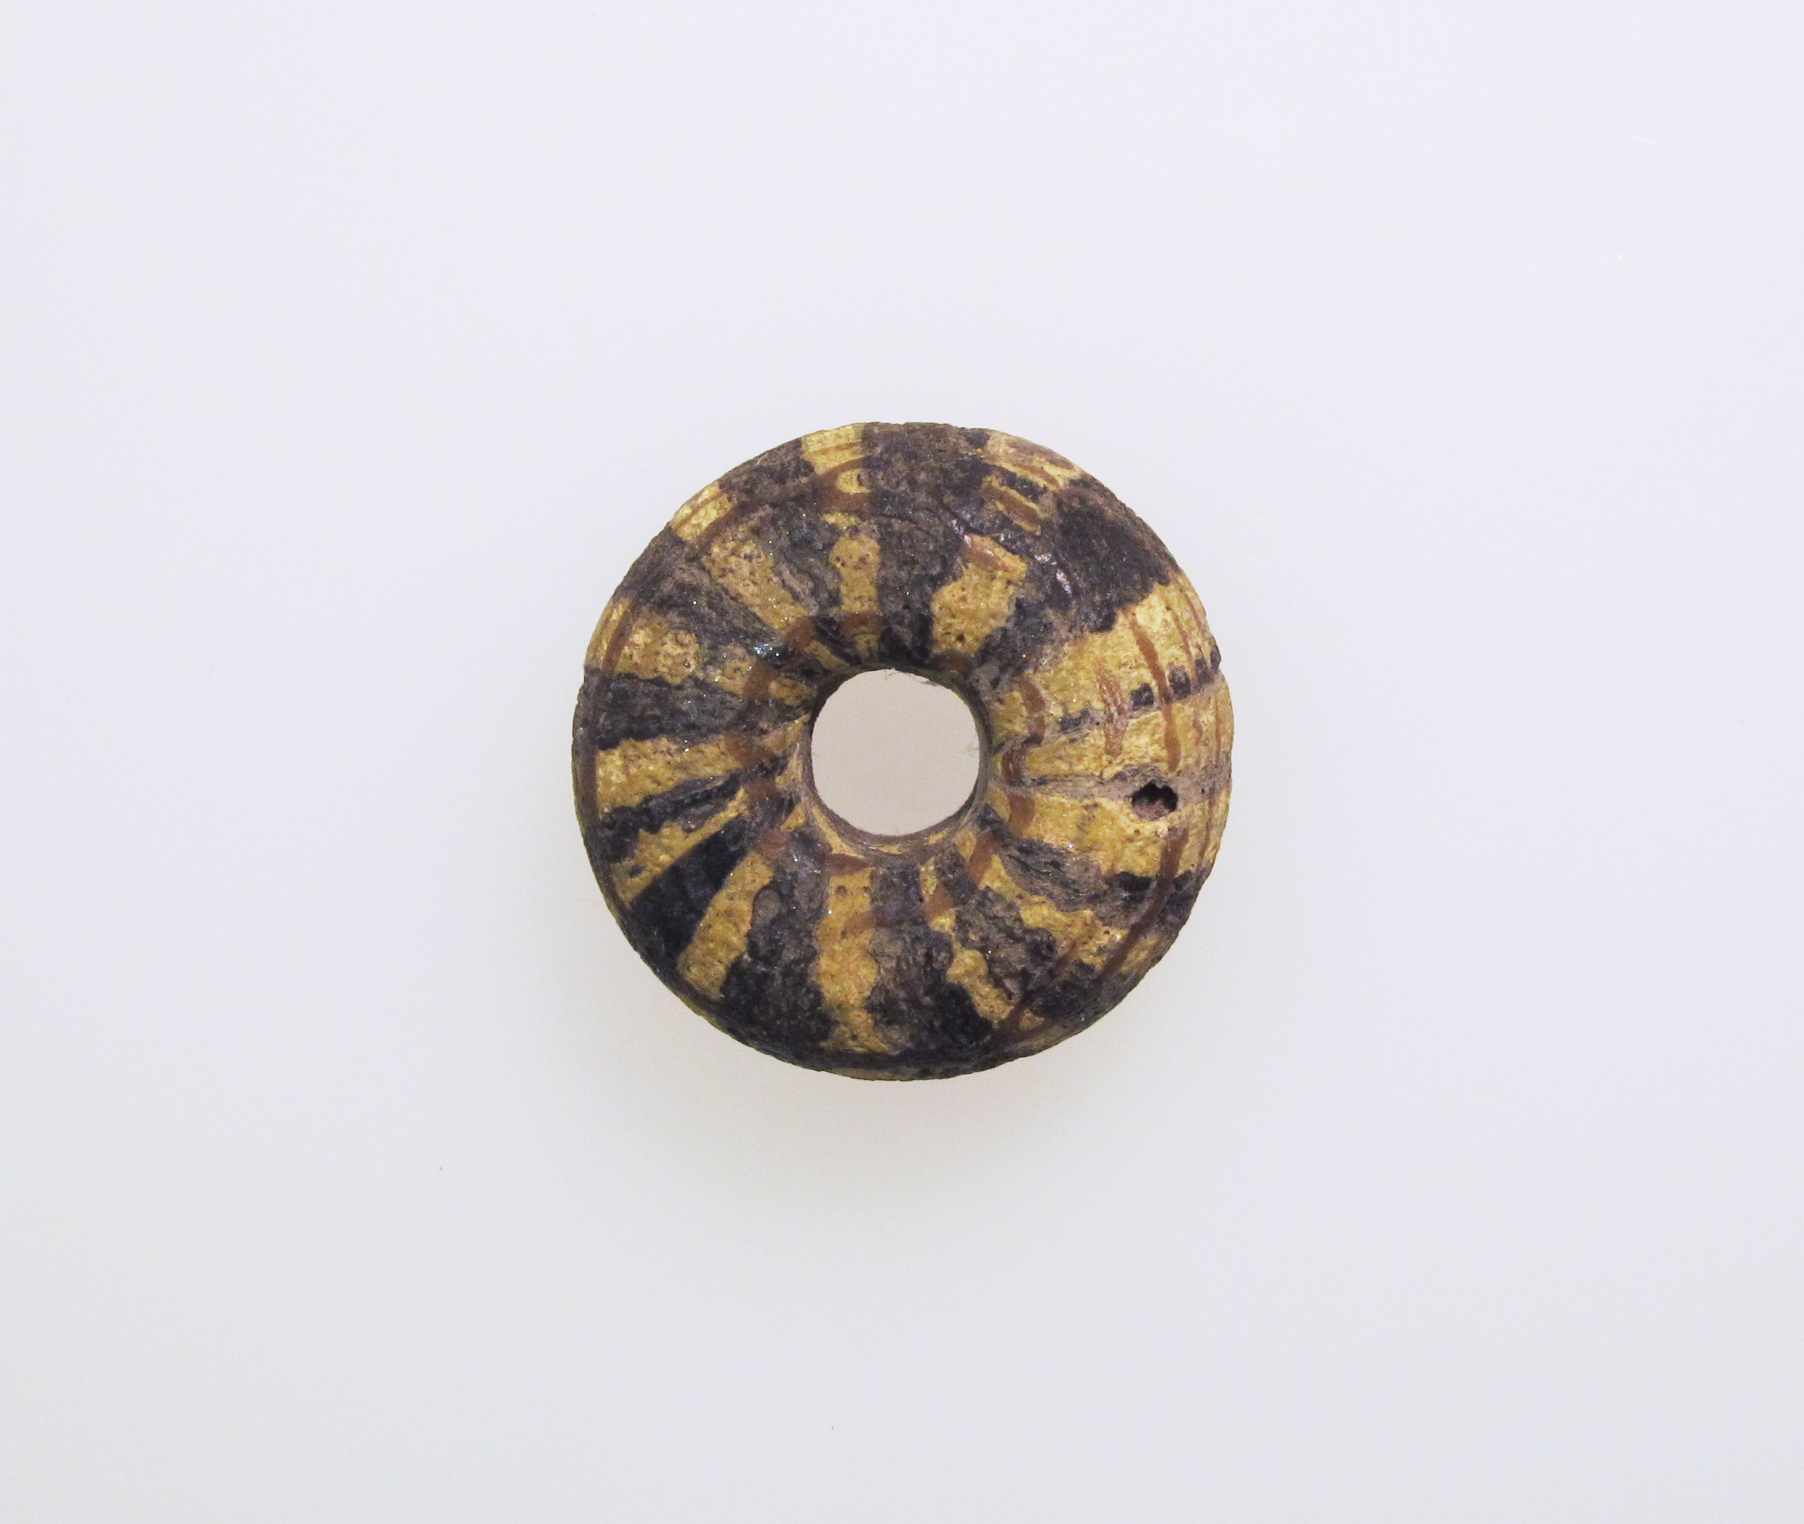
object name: bead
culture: roman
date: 670 BCE-330 CE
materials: glass